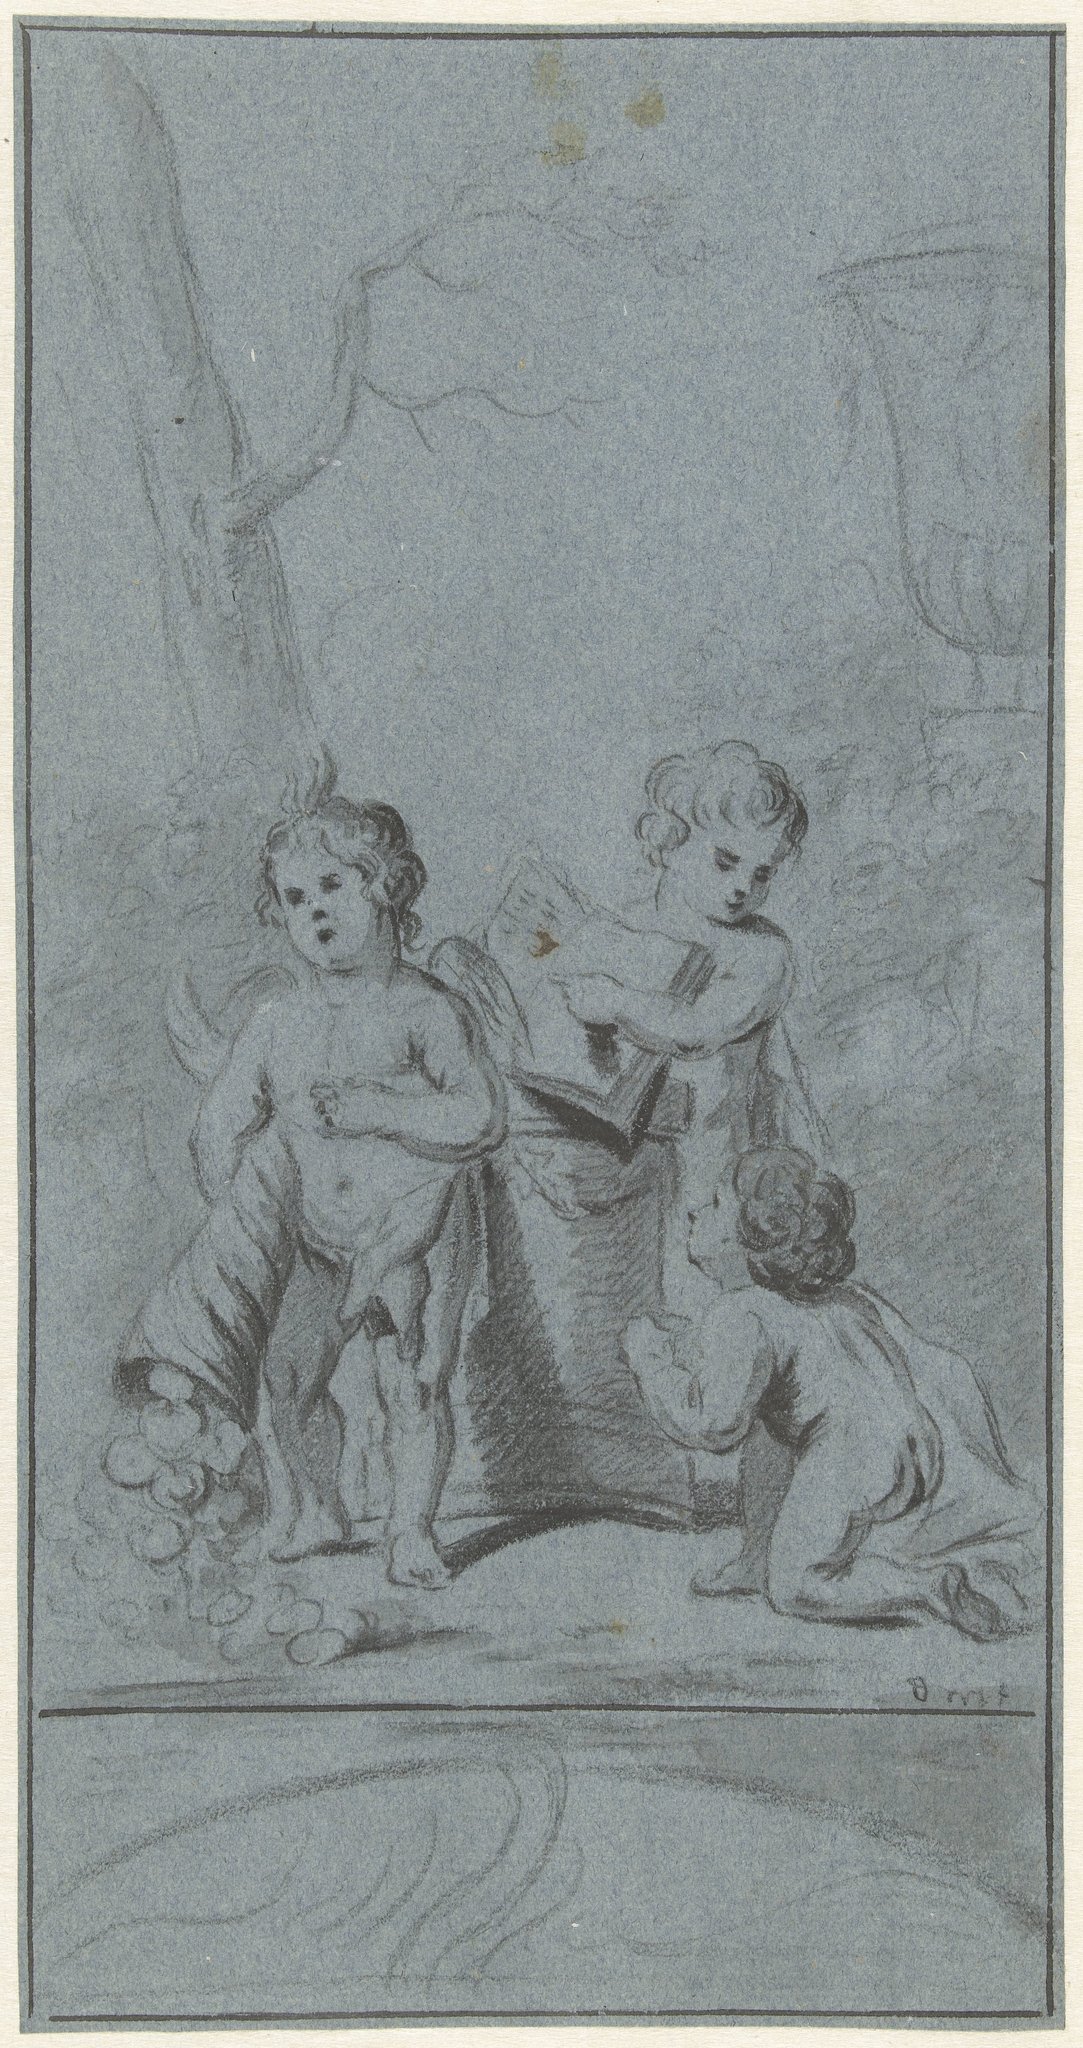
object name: design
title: Drie putti bij een boom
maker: Anonymous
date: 1705-1754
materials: chalk, ink, paper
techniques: brush, pen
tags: devotion, piety; 'divotione' (ripa), cupids: 'amores', 'amoretti', 'putti'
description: Drie putti bij een boom; godsvrucht. Ontwerp voor een decoratie.